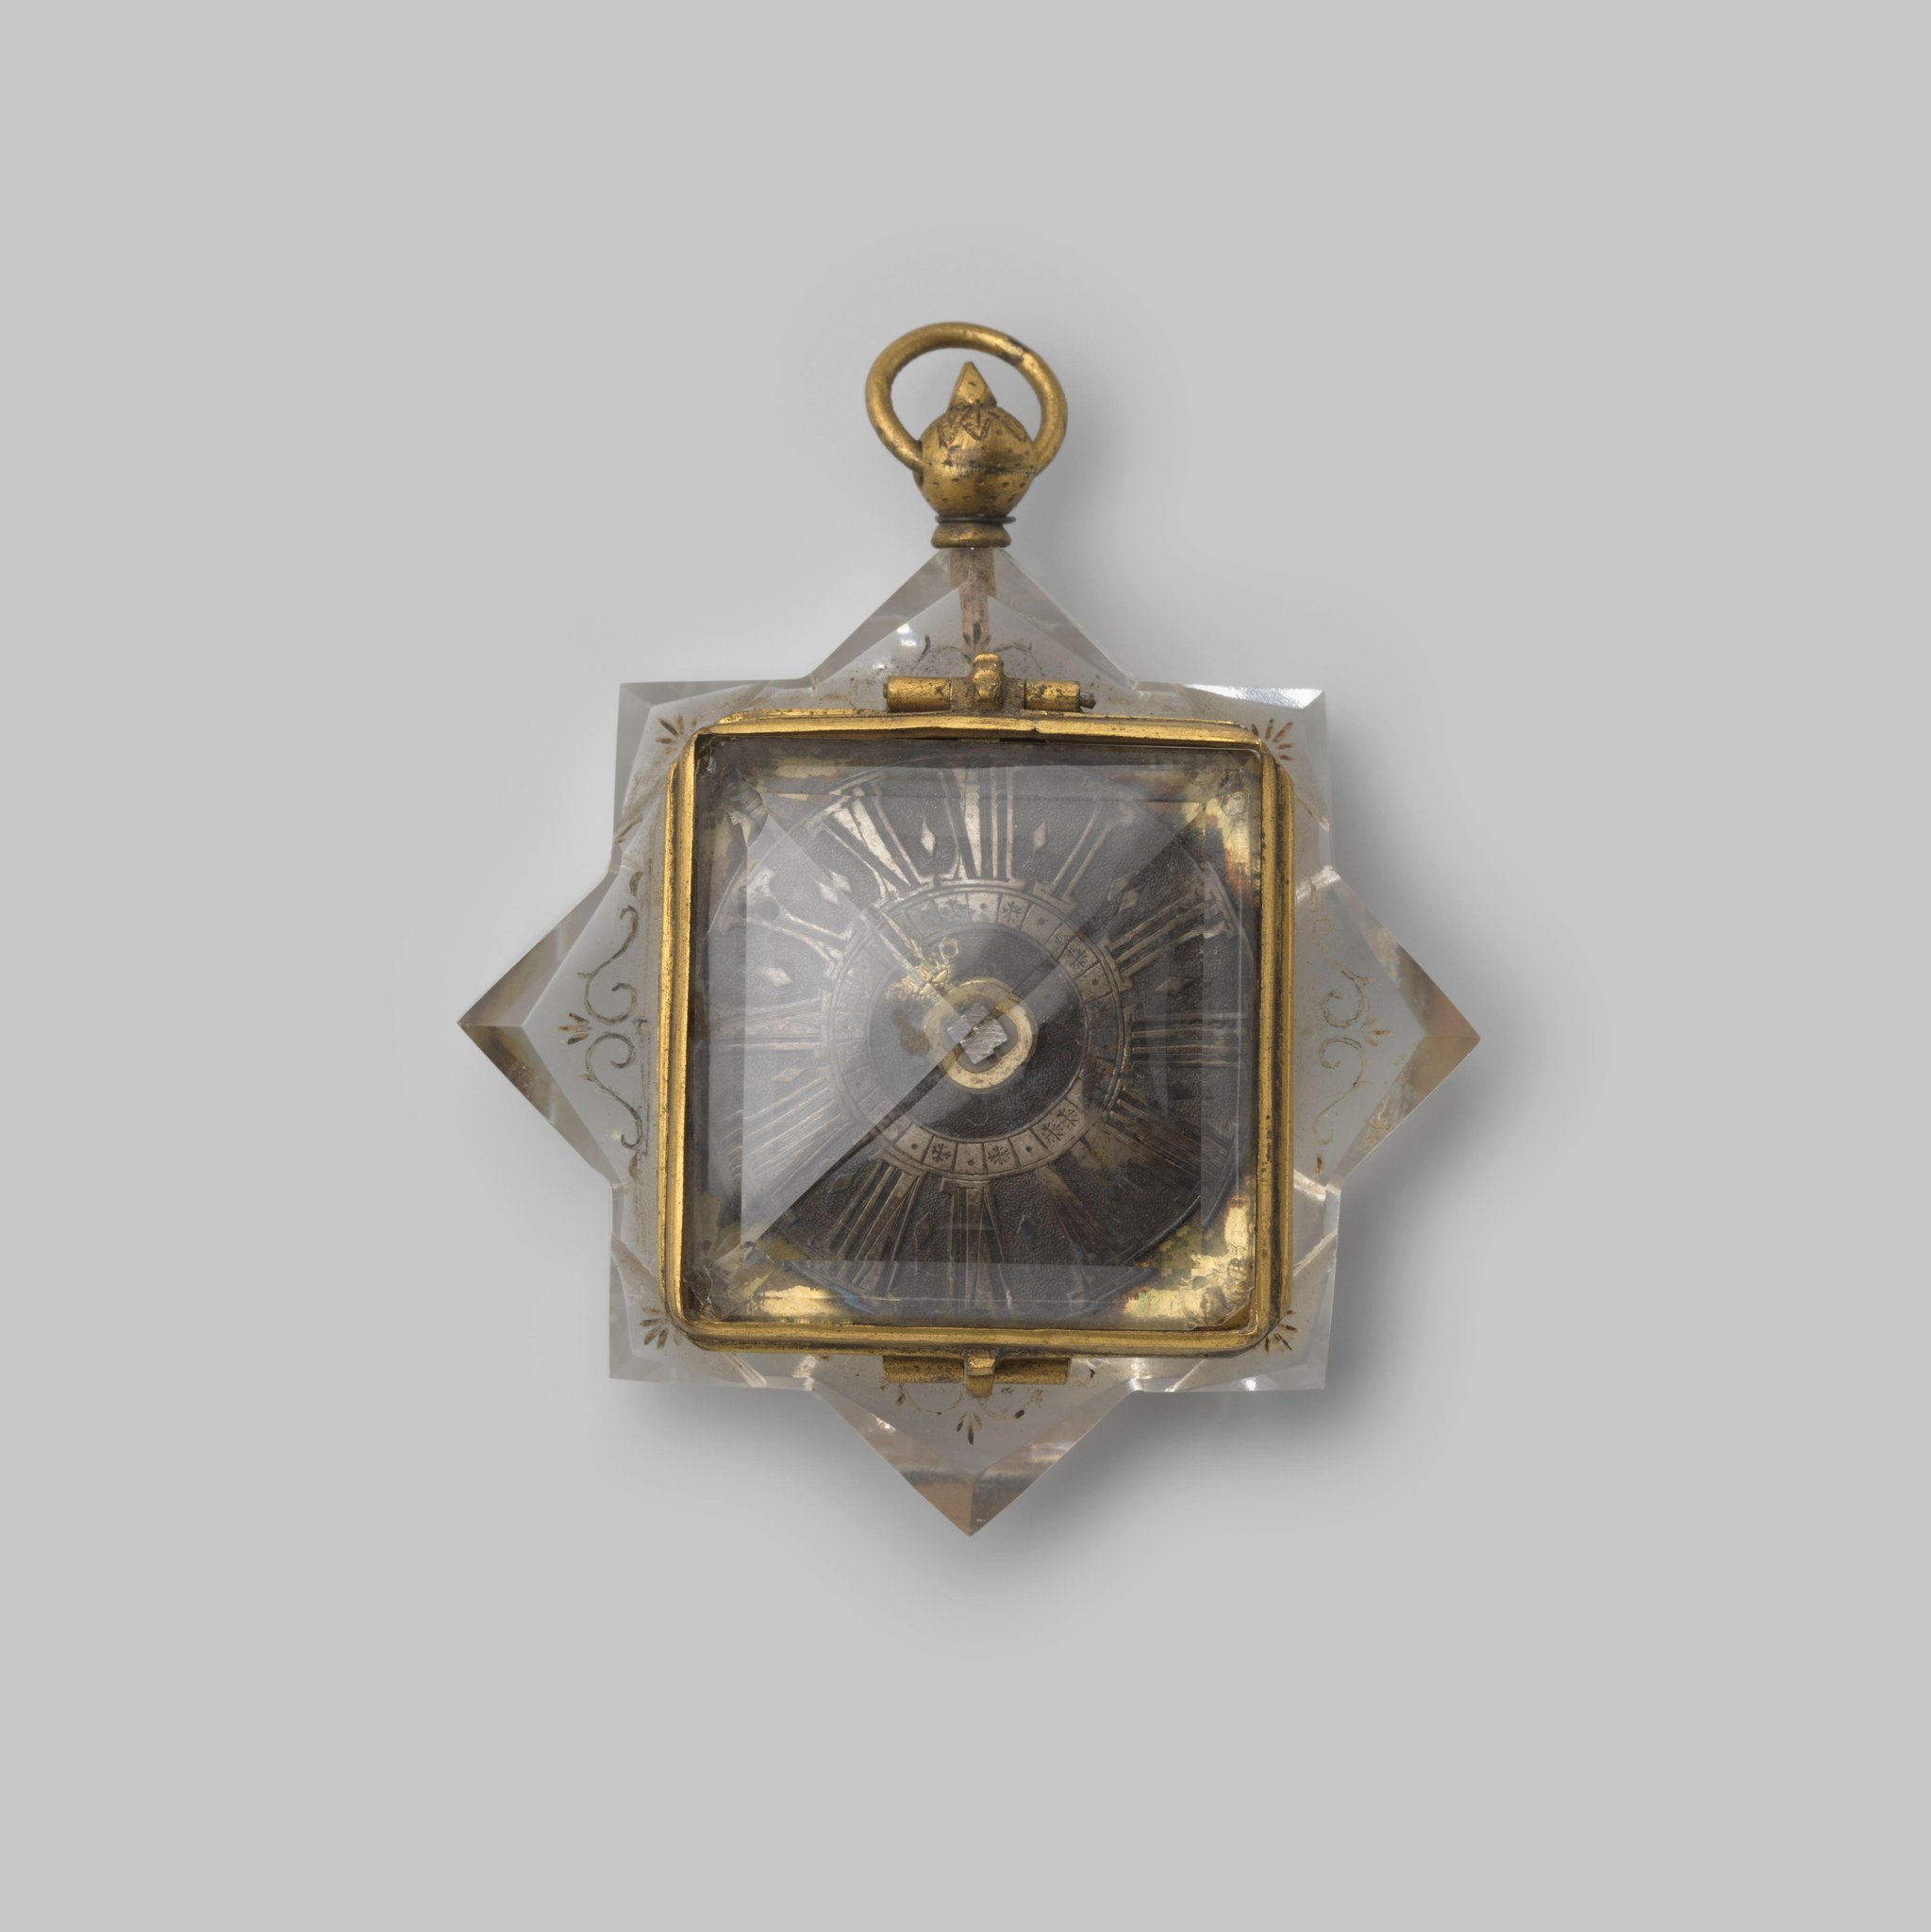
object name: wrist watch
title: Stervormig horloge van kristal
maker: gribelin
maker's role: clockmaker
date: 1400-1950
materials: copper, crystal, silver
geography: paris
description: Stervormig horloge van kristal met een koperen montuur en ring en een zilveren wijzerplaat